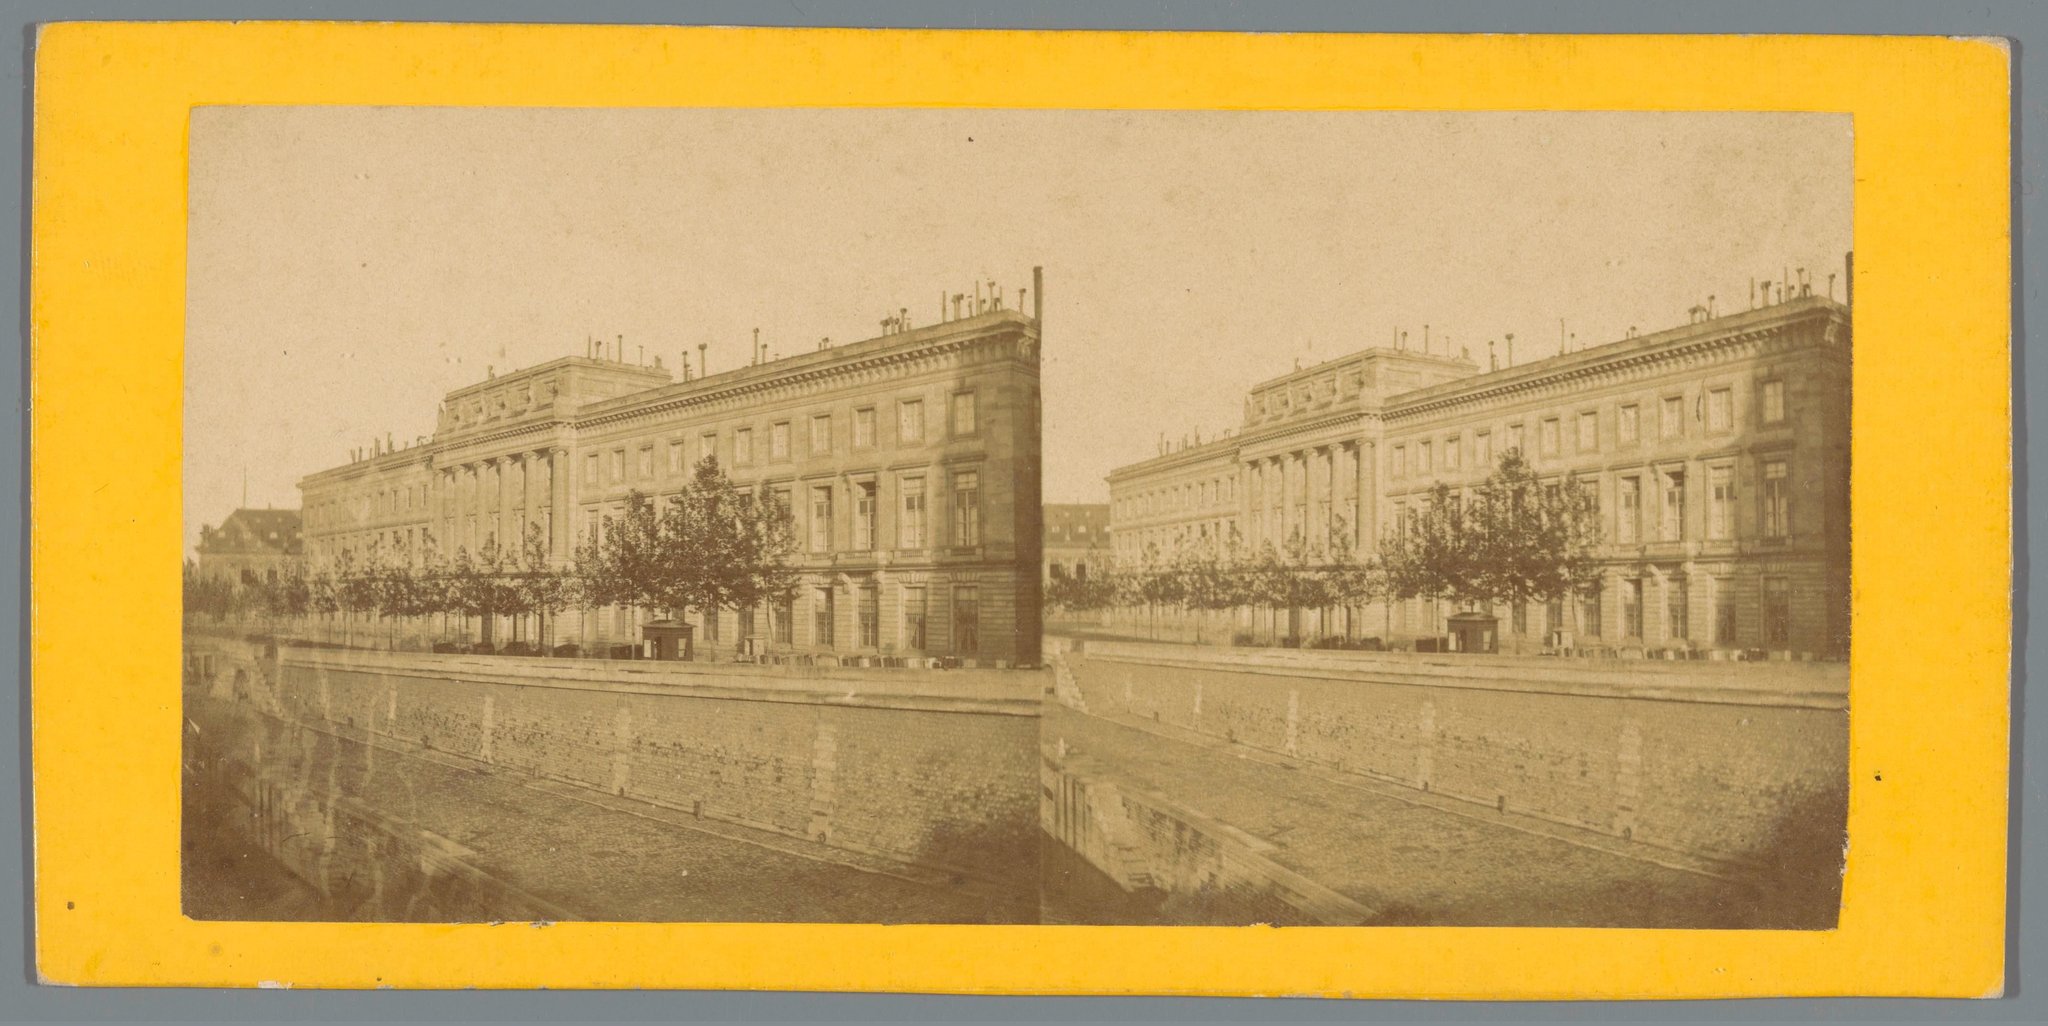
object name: stereograph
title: Gezicht op de Monnaie de Paris in Parijs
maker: Anonymous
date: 1850-1880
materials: cardboard, photographic support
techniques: albumen print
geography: paris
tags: façade (of house or building), money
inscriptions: inscription: ‘Hotel de la Monnaie Paris’